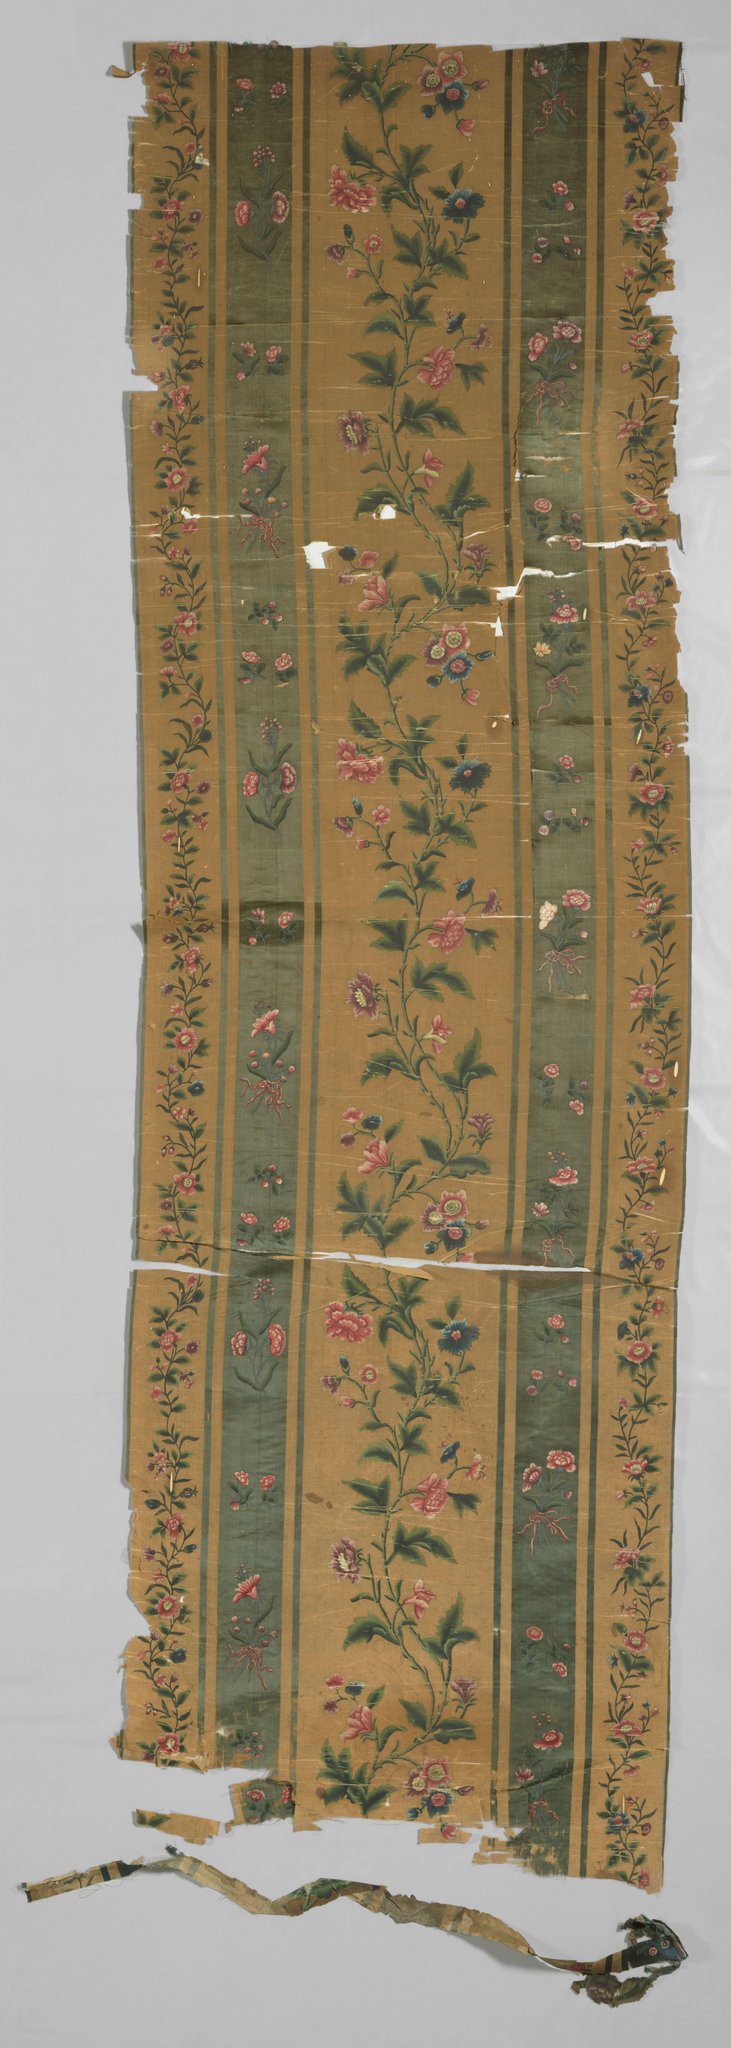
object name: interieuronderdeel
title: Behangsel, op zijde beschilderd met strepen, gestrikte boeketten, afgewisseld met losse bloemen en opstaande ranken met bladeren en bloemvariaties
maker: Anonymous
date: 1750-1800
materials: paint, silk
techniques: painted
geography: northern netherlands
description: Een wandvak met op zijde beschilderd behangsel. De crème-witte grond in ripsbinding, wordt per baan door twee grijsblauwe strepen in satijnbinding, verdeeld in een breed middenvak en smallere zijvakken. Op het blauw zijn gestrikte boeketten afgewisseld met losse bloemen geschilderd, op het middenvak een opstaande rank met bladeren en bloemvariaties in roze, lila en blauw en op de zijkanten een smallere rank met bloemen.